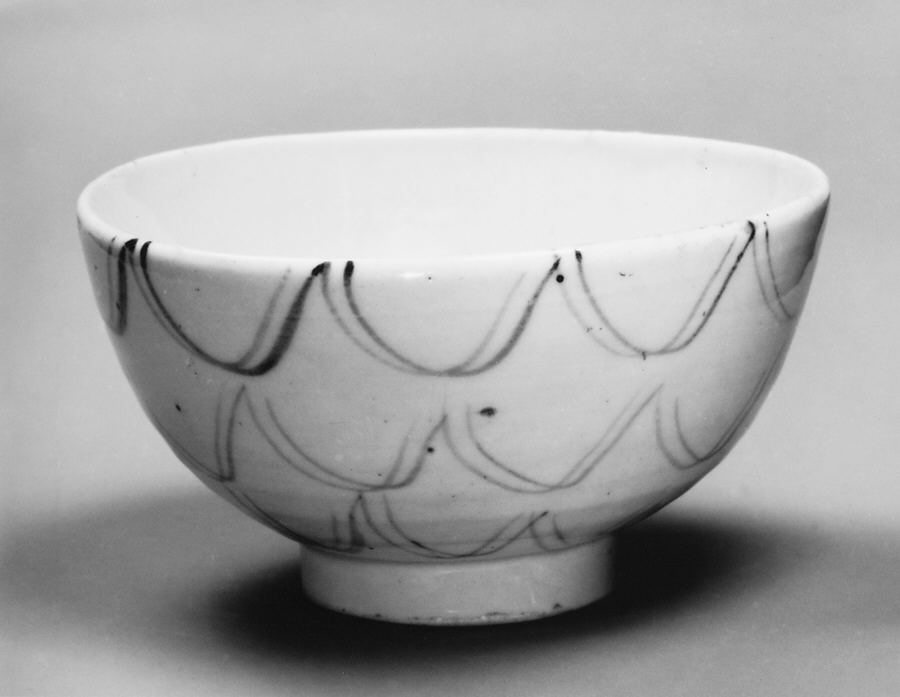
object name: bowl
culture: japanese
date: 1701-1800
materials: porcelain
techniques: underglaze